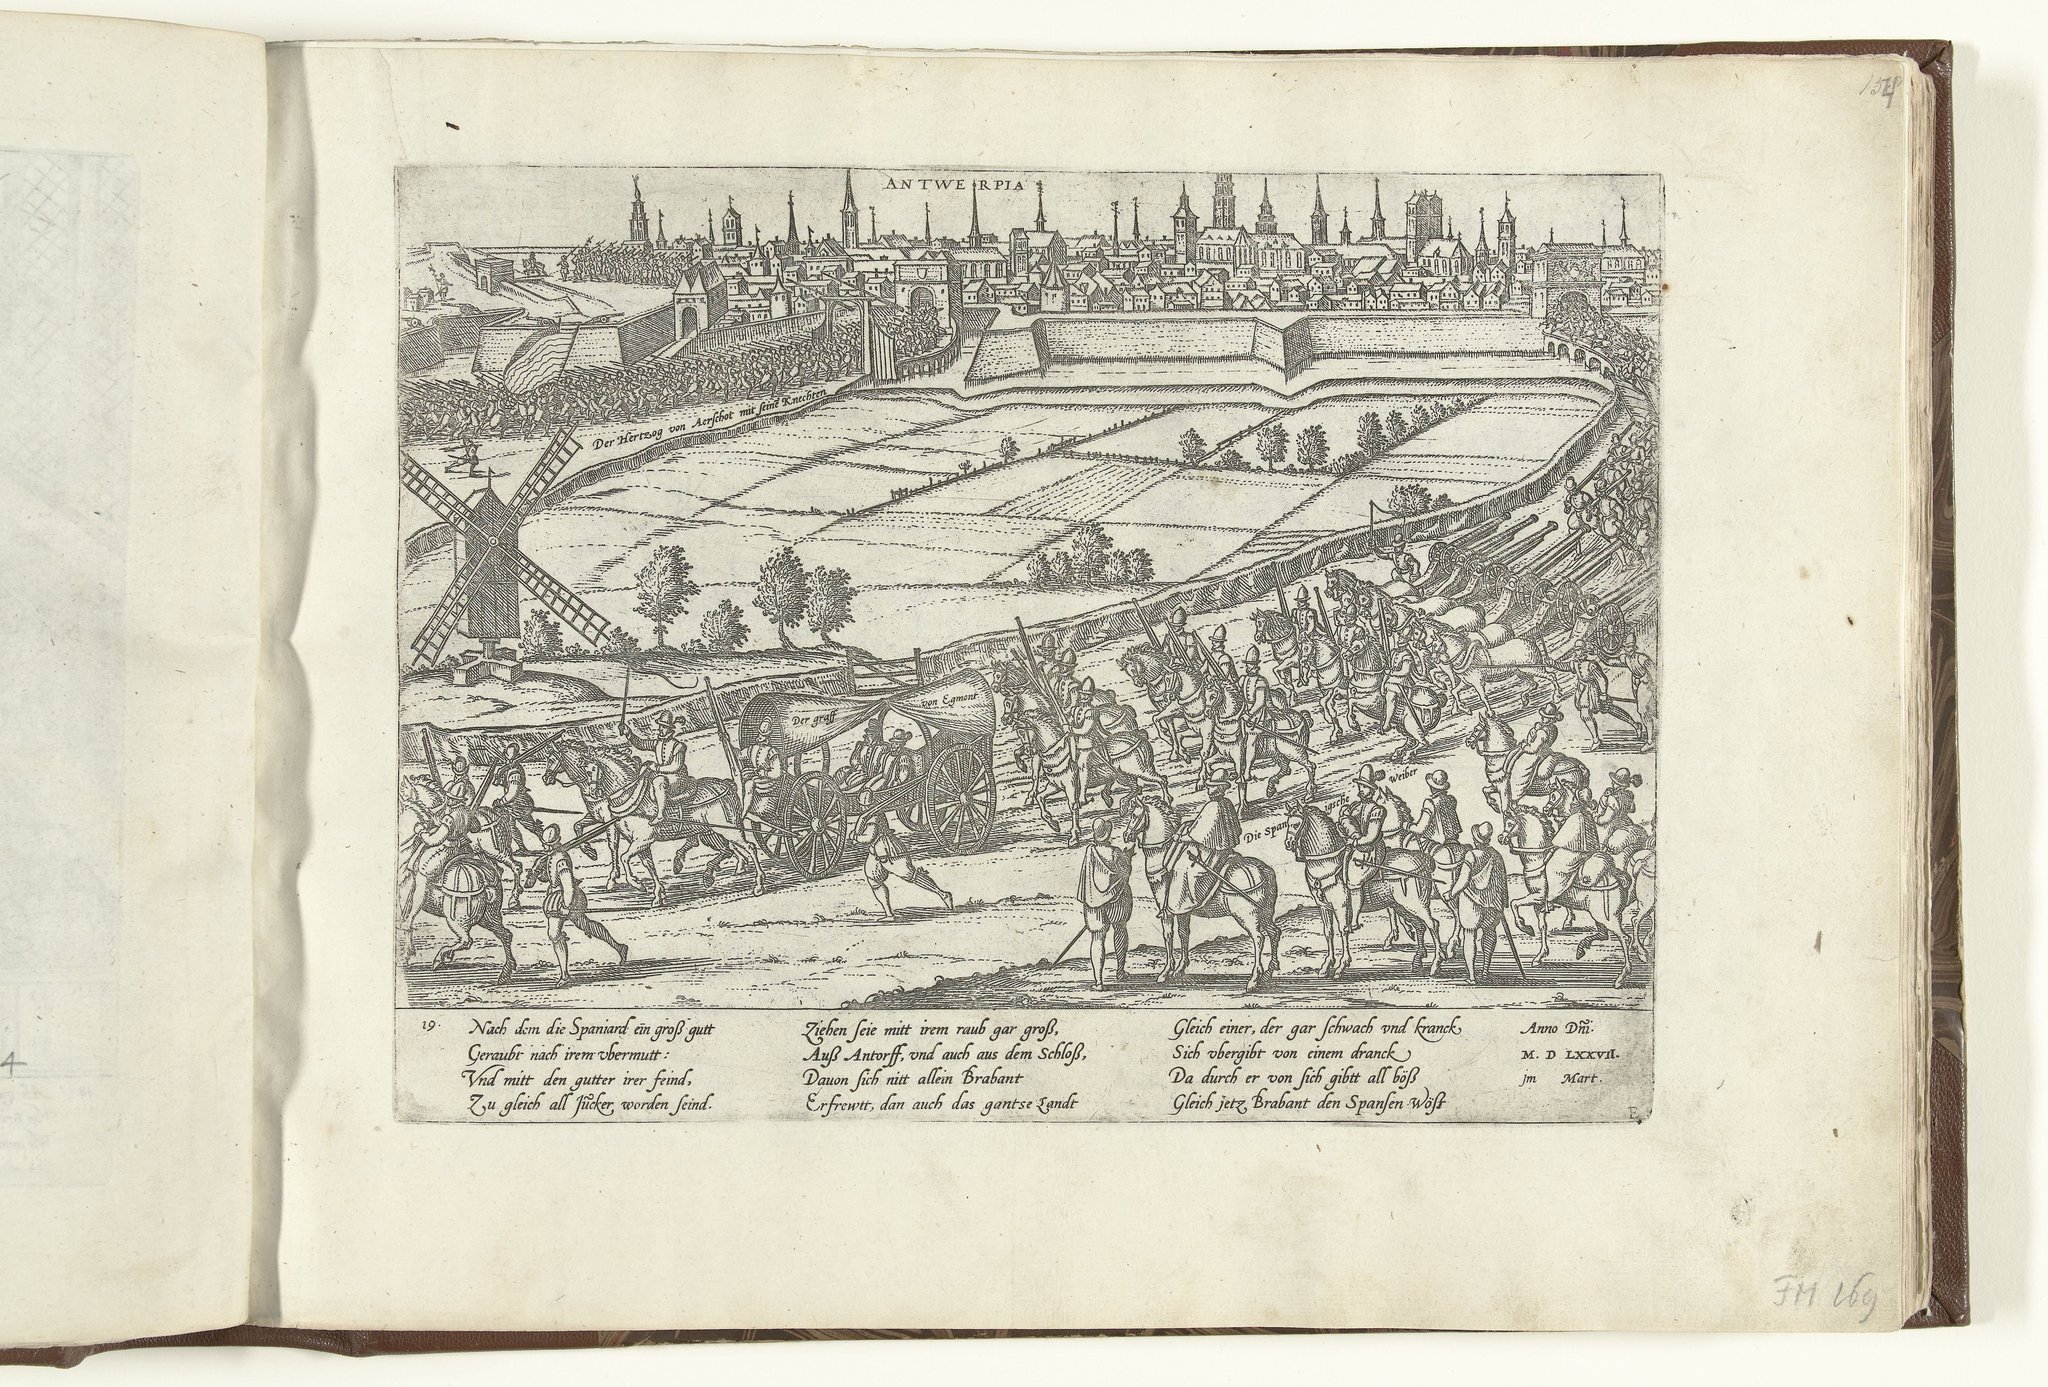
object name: print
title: Aftocht van Spanjaarden uit Antwerpen, 1577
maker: frans hogenberg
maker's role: print maker, publisher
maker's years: 1538-1590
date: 1577-1579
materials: paper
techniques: etching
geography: cologne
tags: brussels, earl, antwerp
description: Vertrek van de Spaanse troepen uit Antwerpen, 20 maart 1577. Een lange stoet van soldaten, ruiters en kanonnen, maar ook vrouwen en kinderen verlaat de stad. Op de voorgrond een koets met de graaf van Egmond. Links op de achtergrond trekken de troepen van de hertog van Aarschot de stad binnen. Met onderschrift van 12 regels in het Duits. Genummerd: 19.